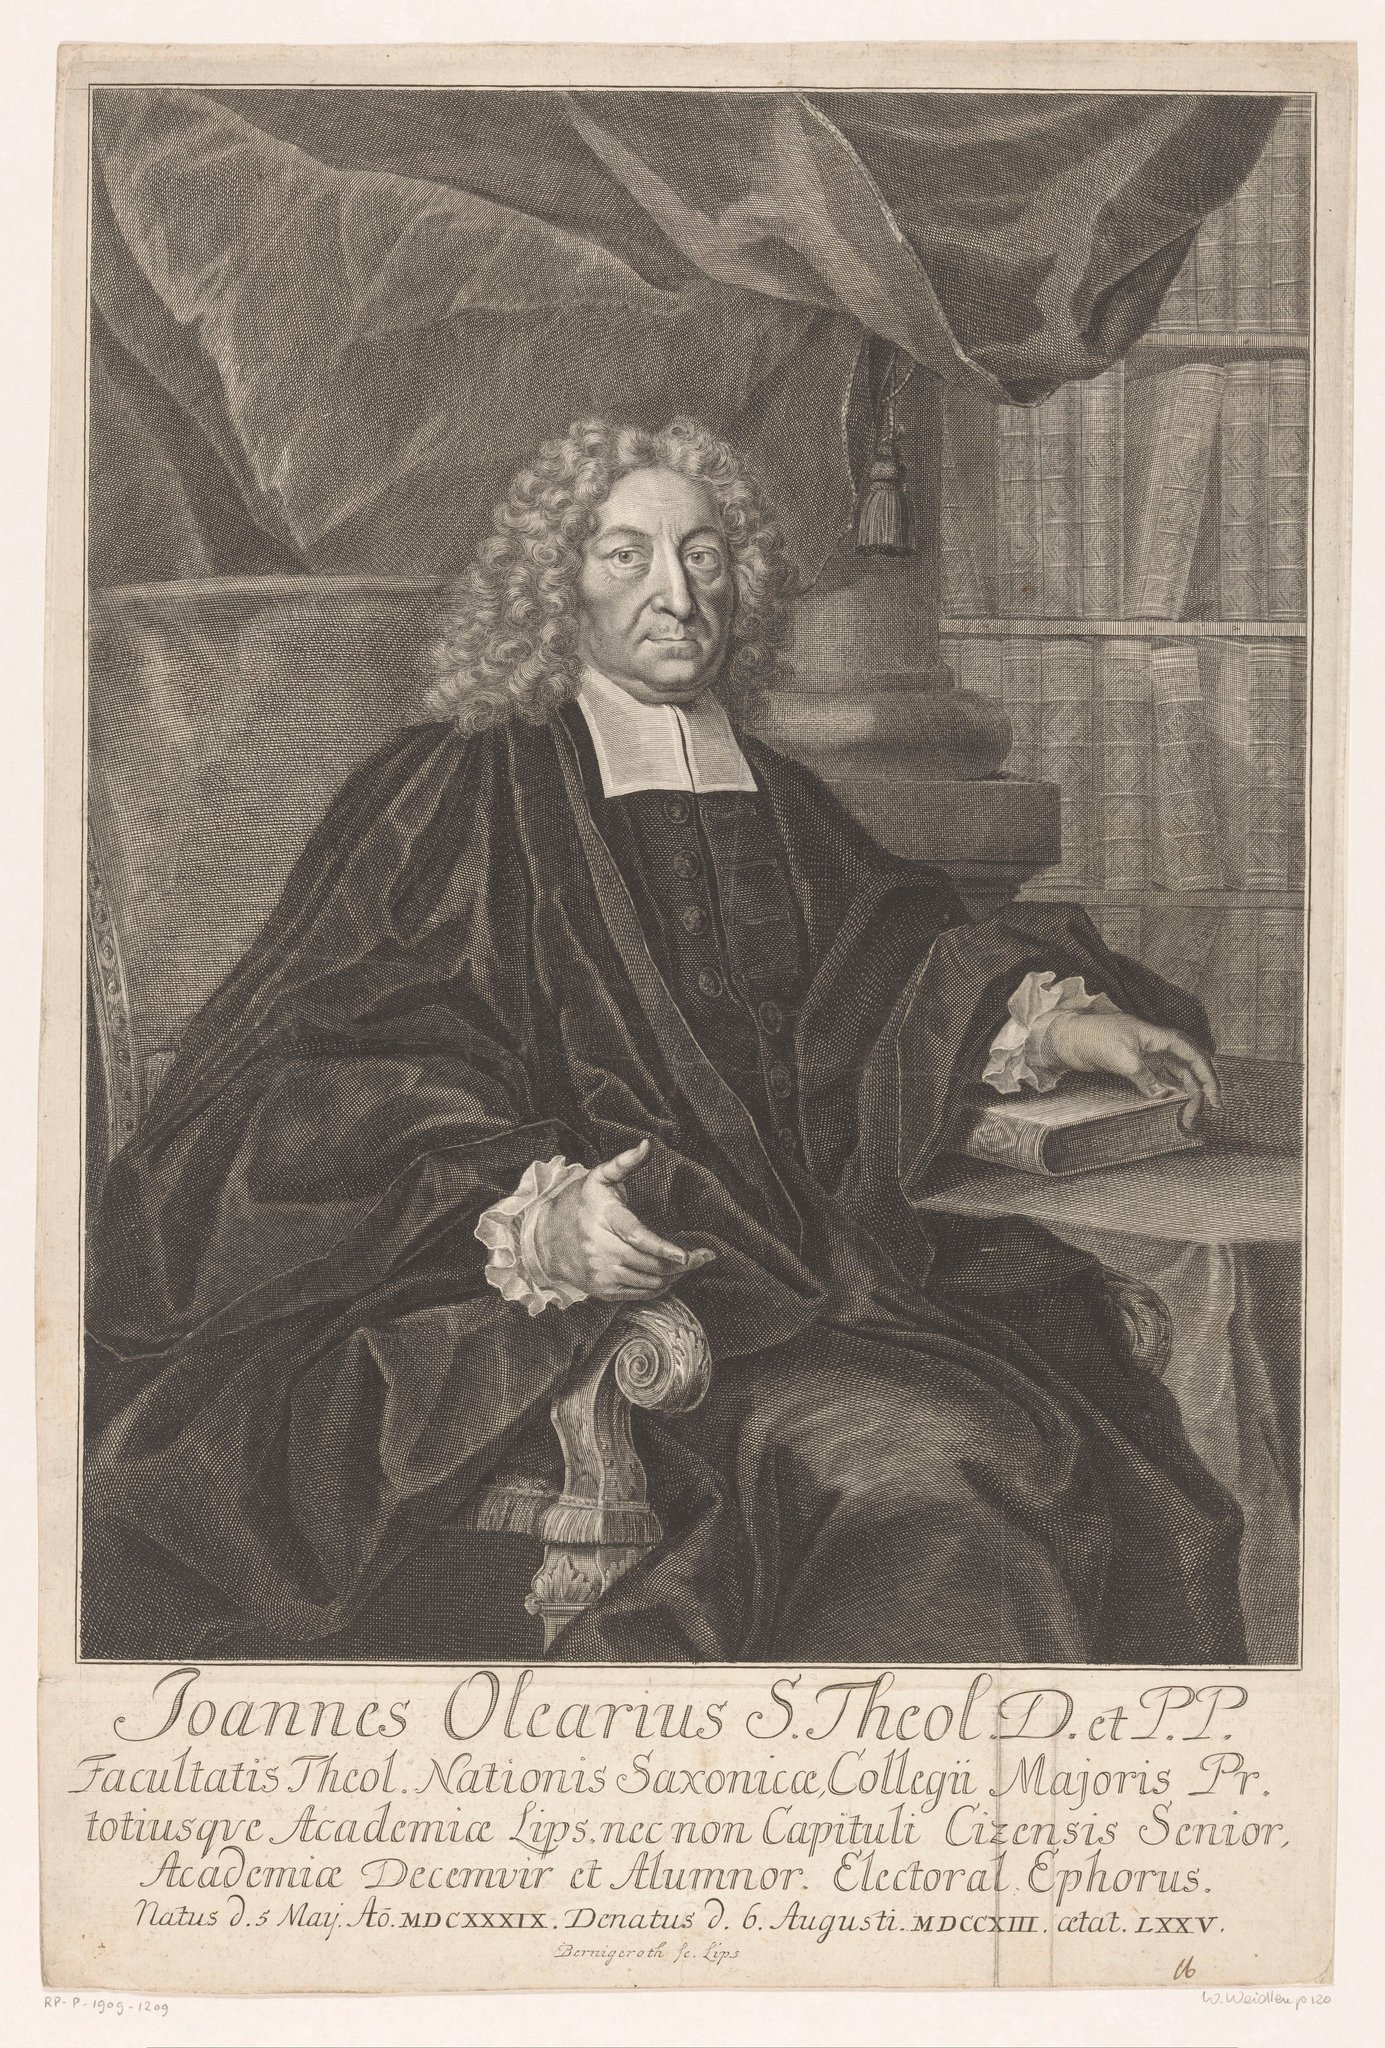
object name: print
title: Portret van Johannes Olearius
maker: martin bernigeroth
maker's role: print maker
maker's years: 1670-1733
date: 1713-1733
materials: paper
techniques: engraving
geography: leipzig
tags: johannes olearius, bookshelves, historical persons, book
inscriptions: collector's mark: Lugt 2228